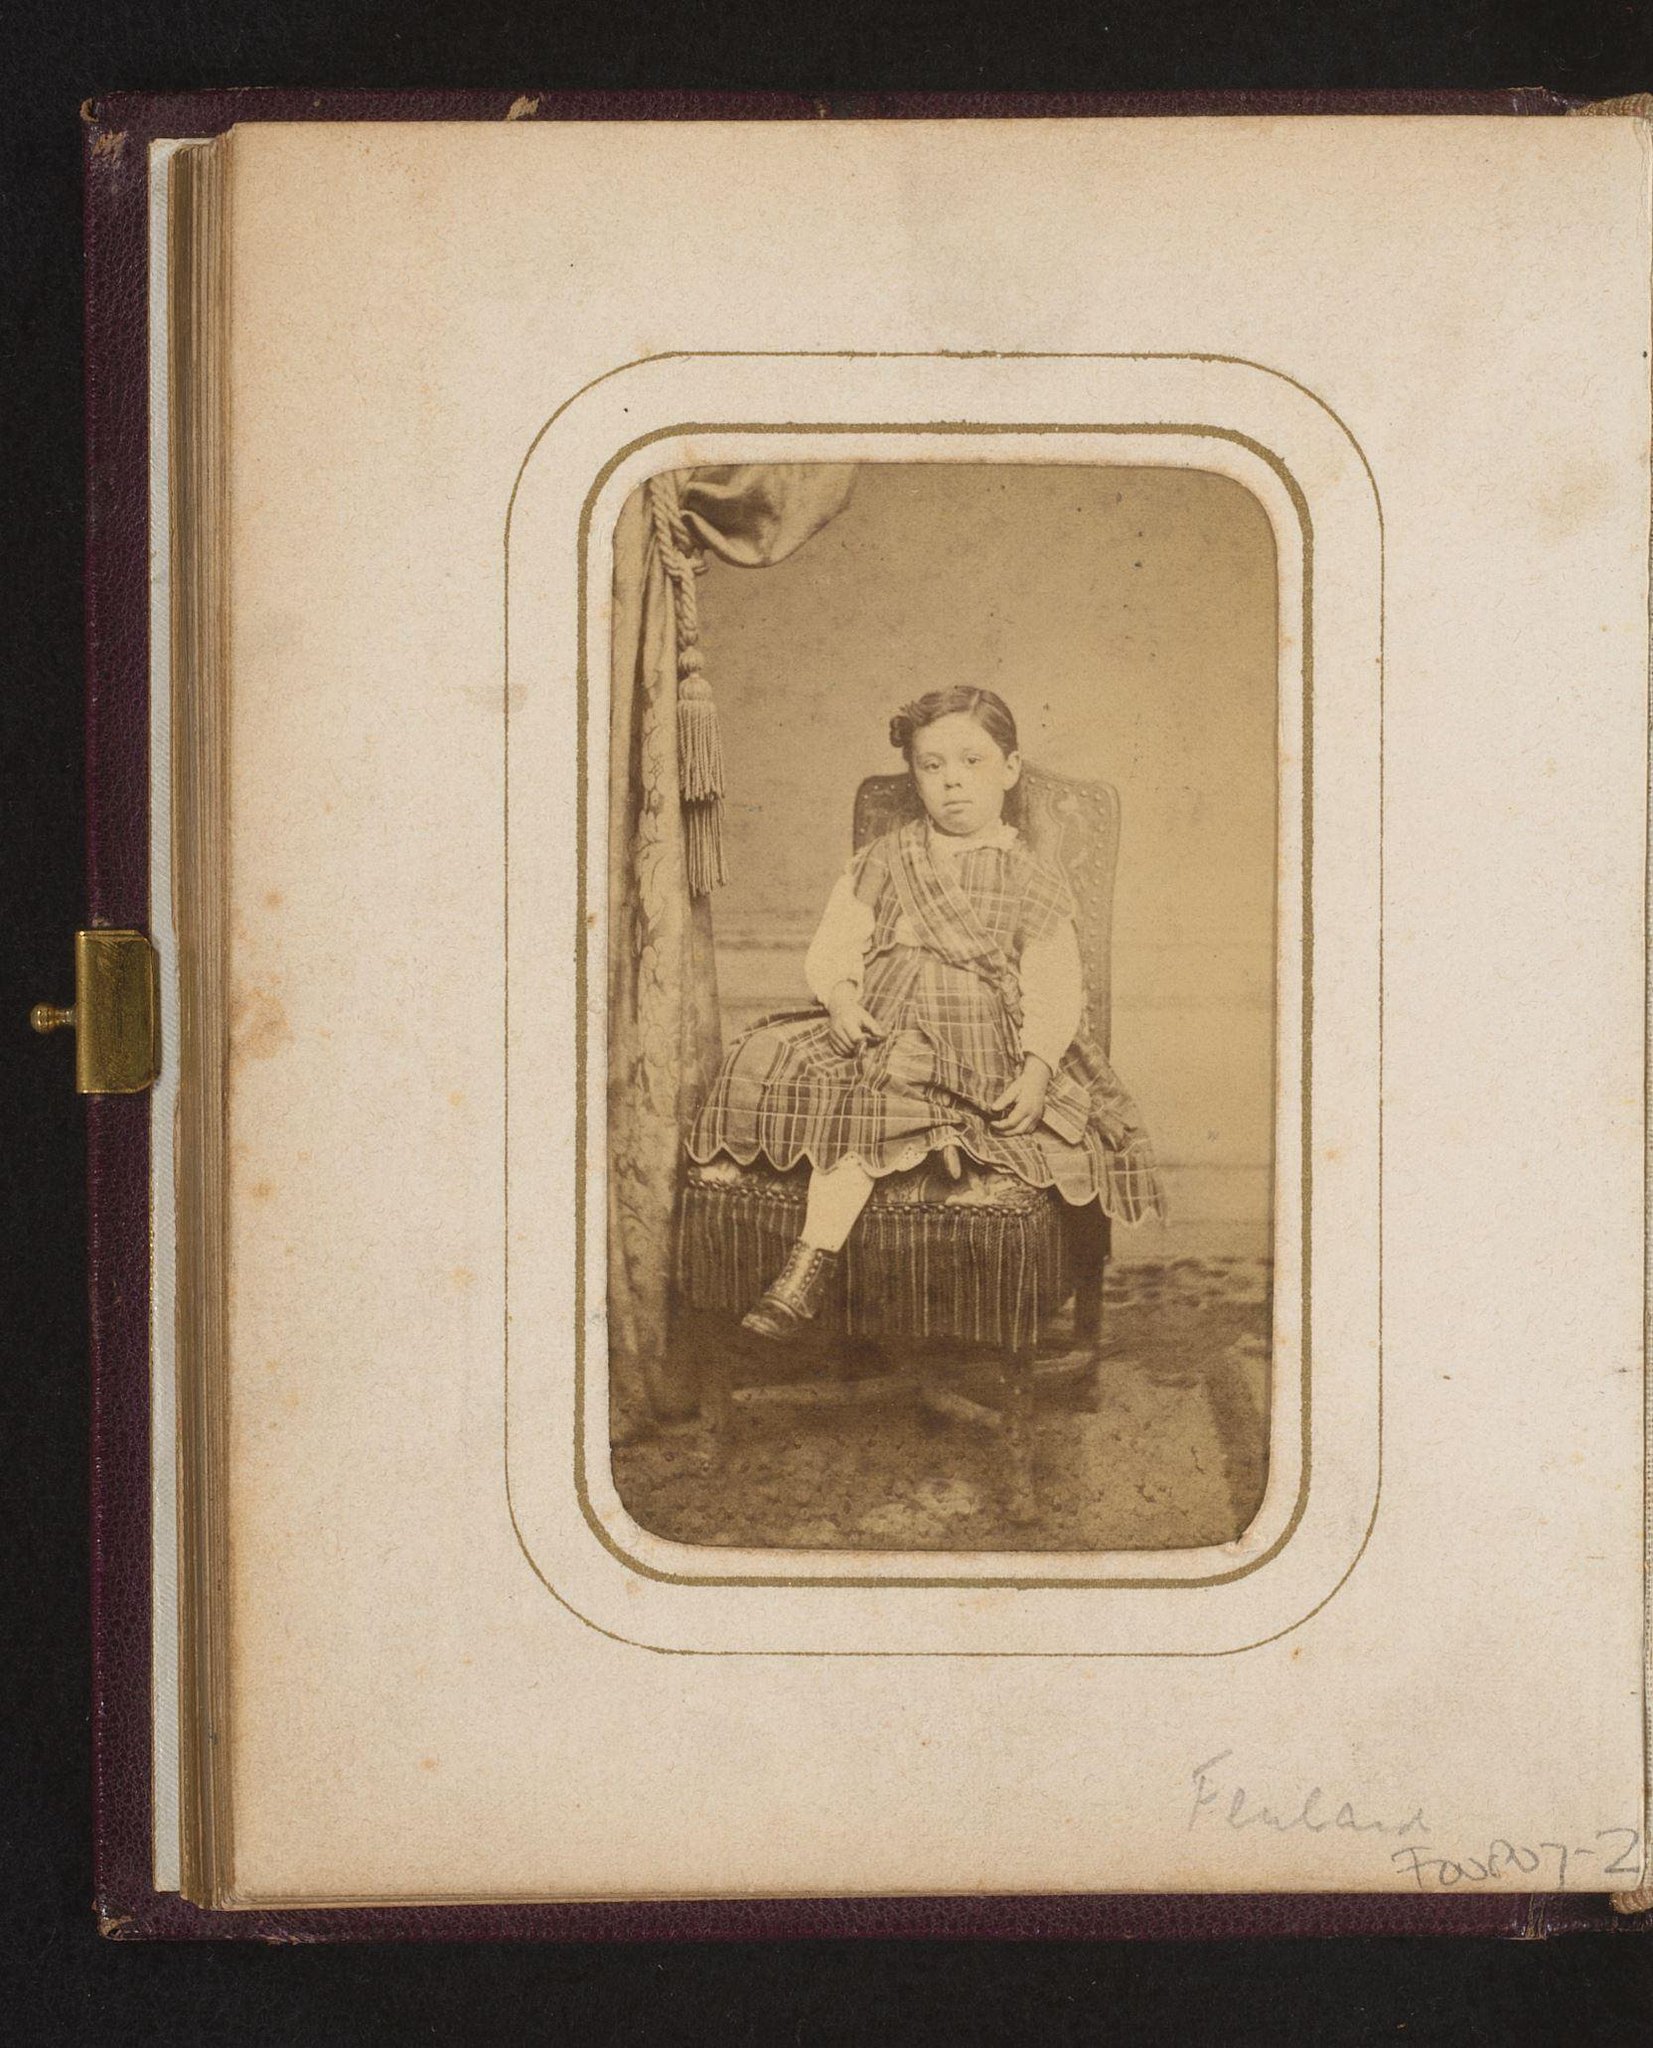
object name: album leaf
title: Portret van een meisje in geruite jurk, zittend op een stoel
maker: alexandre feulard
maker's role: fotograaf, miniatuurschilder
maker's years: 1813-1886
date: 1865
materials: cardboard, photographic support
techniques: albumen print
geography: le havre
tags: sitting figure - aa - female human figure, historical persons - bb - woman, chair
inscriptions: inscription: ‘A. Feulard/ HÂVRE’, annotation: ‘4 Novembre 1865/ 4 ans.’, annotation: ‘Feulard’